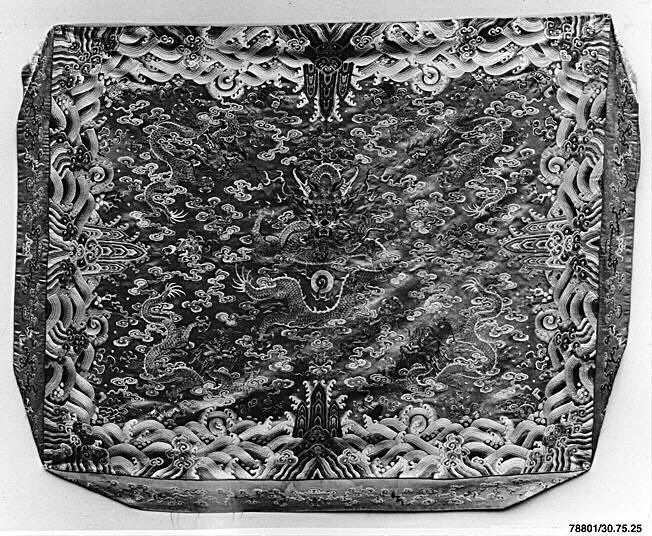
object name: cushion cover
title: Cushion Cover for Throne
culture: chinese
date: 1736-1795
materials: metal thread, silk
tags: dragons